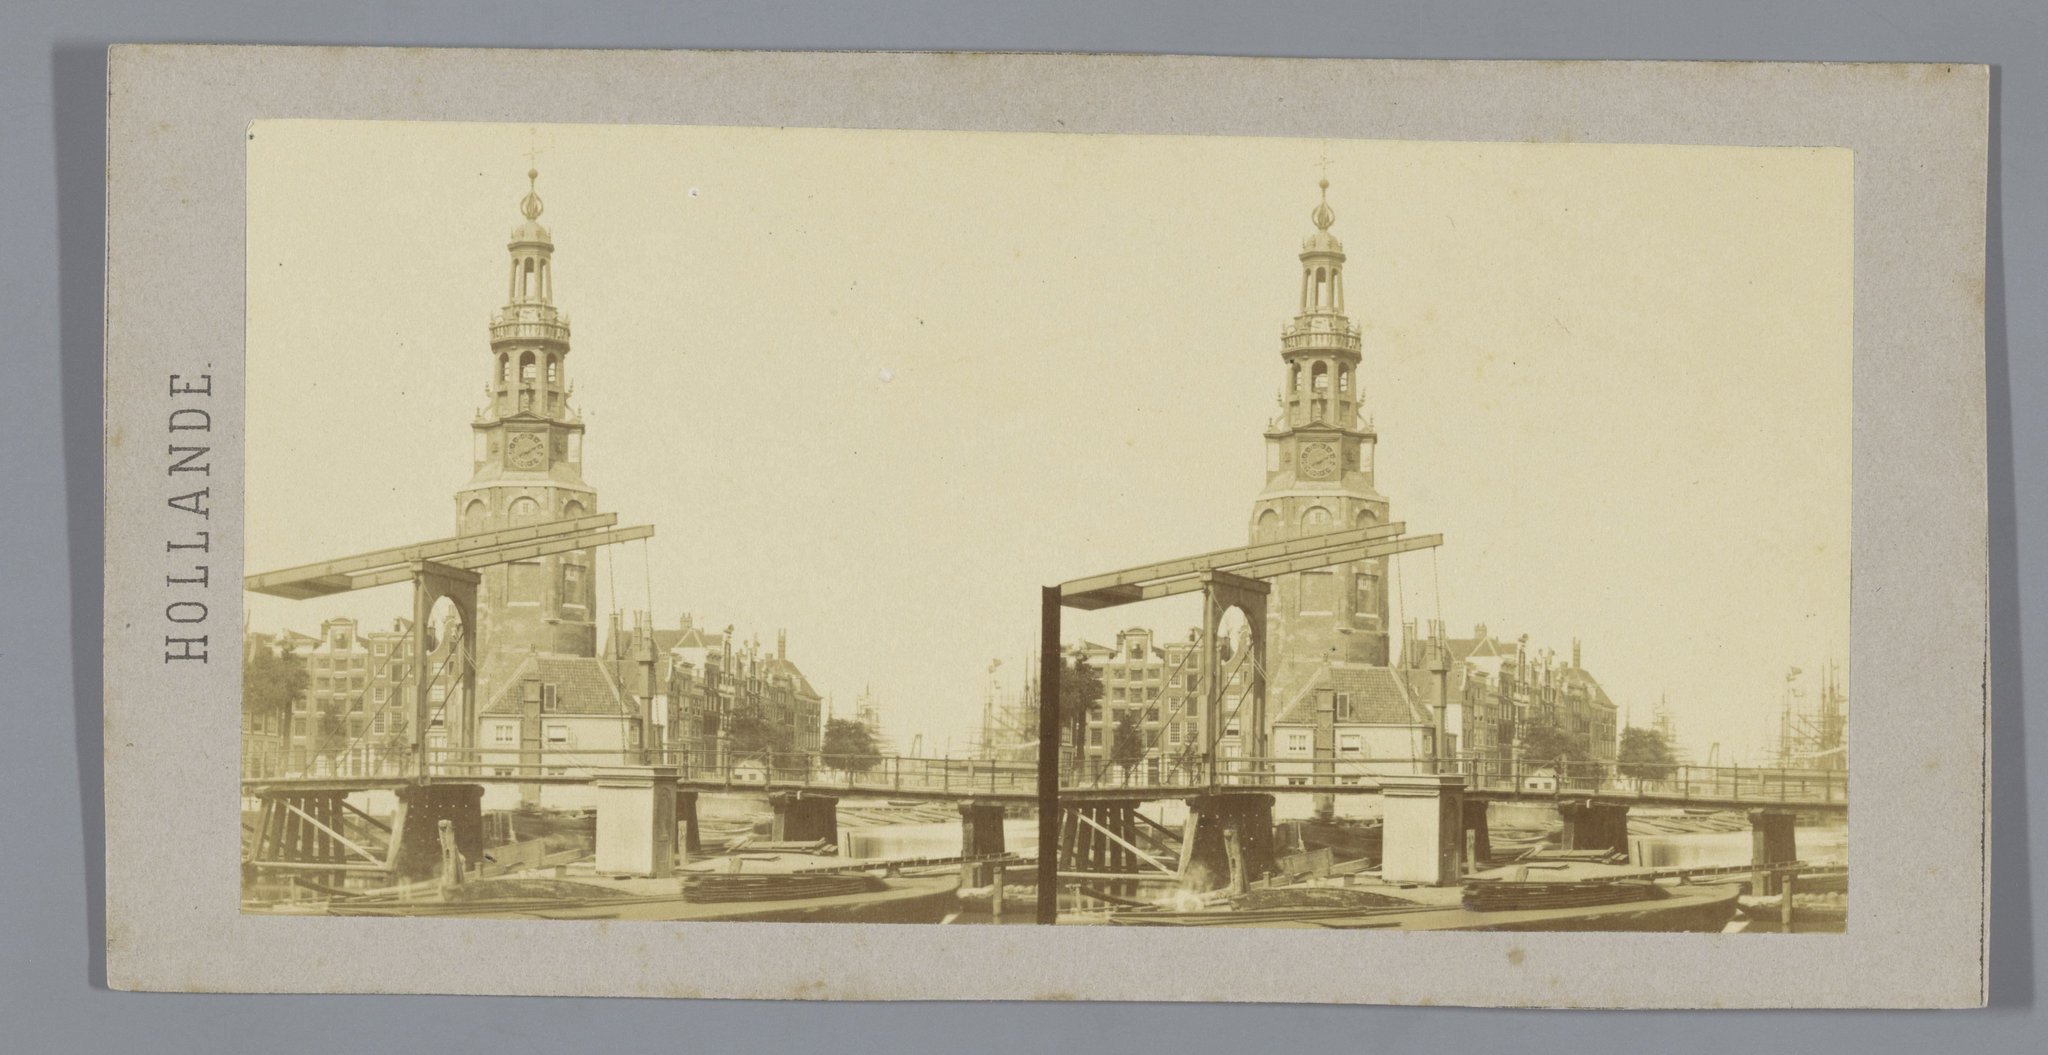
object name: stereograph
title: Hollande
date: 1858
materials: cardboard, paper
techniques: albumen print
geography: amsterdam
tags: tower, clock tower ~ monumental adornment, bridge in city across river, canal, etc., amsterdam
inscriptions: number: ‘N. 9’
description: De Oudeschans met Montelbaanstoren gezien in noordelijk richting naar het IJ.